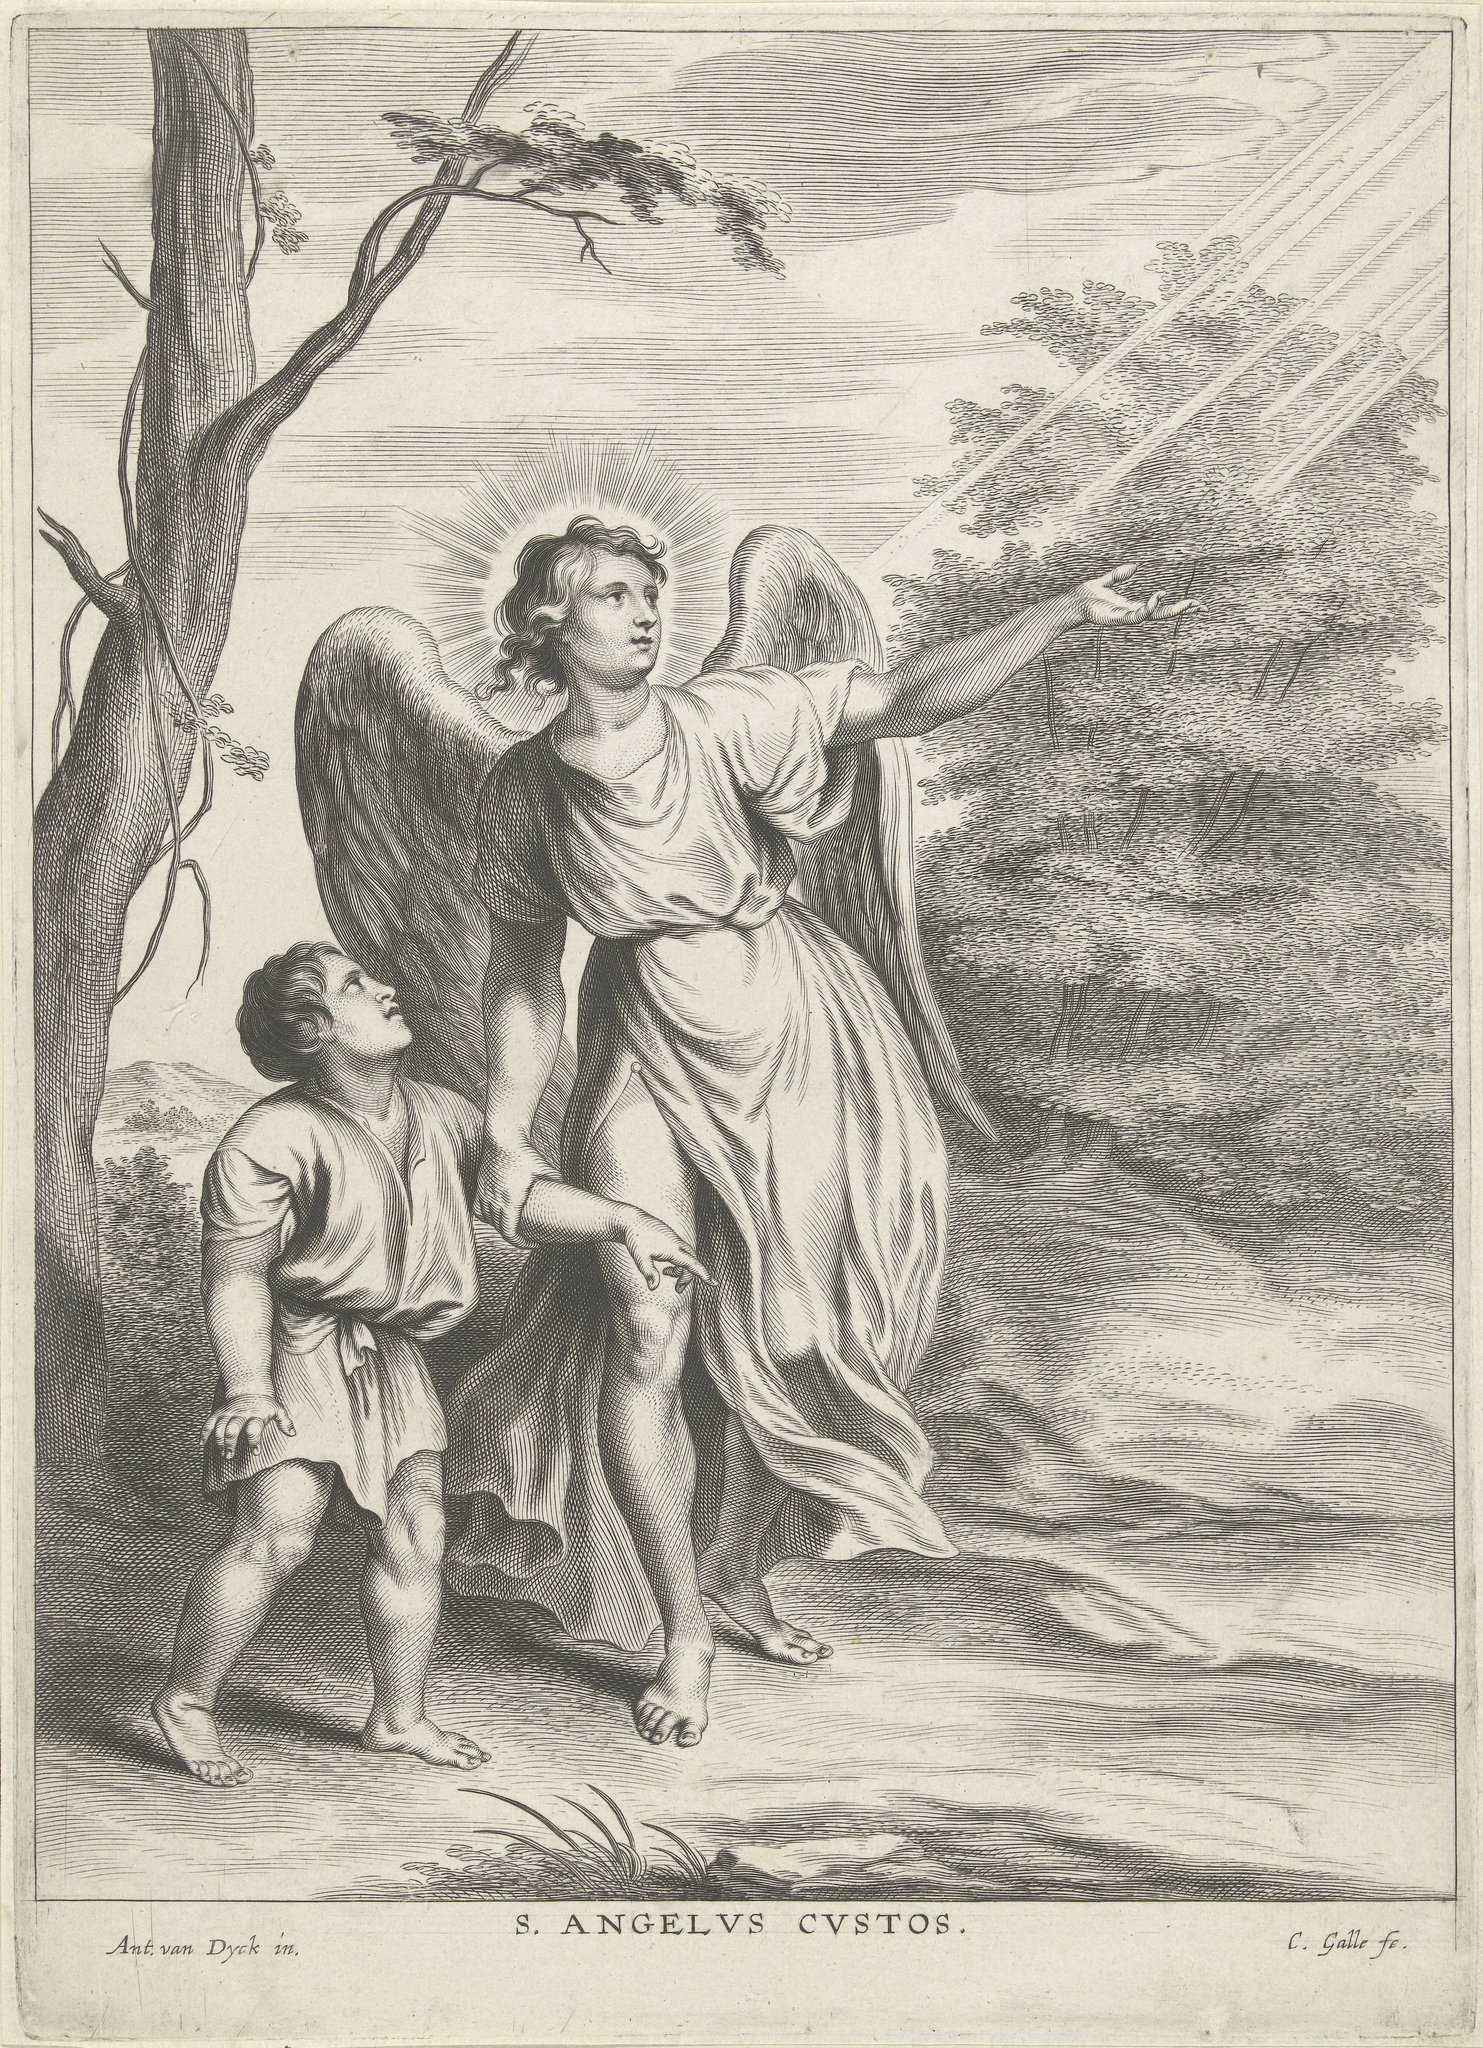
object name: print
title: S. Angelvs Cvstos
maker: anthony van dyck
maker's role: draughtsman, painter, print maker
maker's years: 1599-1641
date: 1600-1699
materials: paper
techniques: engraving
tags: guardian angel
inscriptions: collector's mark: Lugt 240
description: Een engel houdt een jongetje bij de arm vast en wijst hem de goede weg.